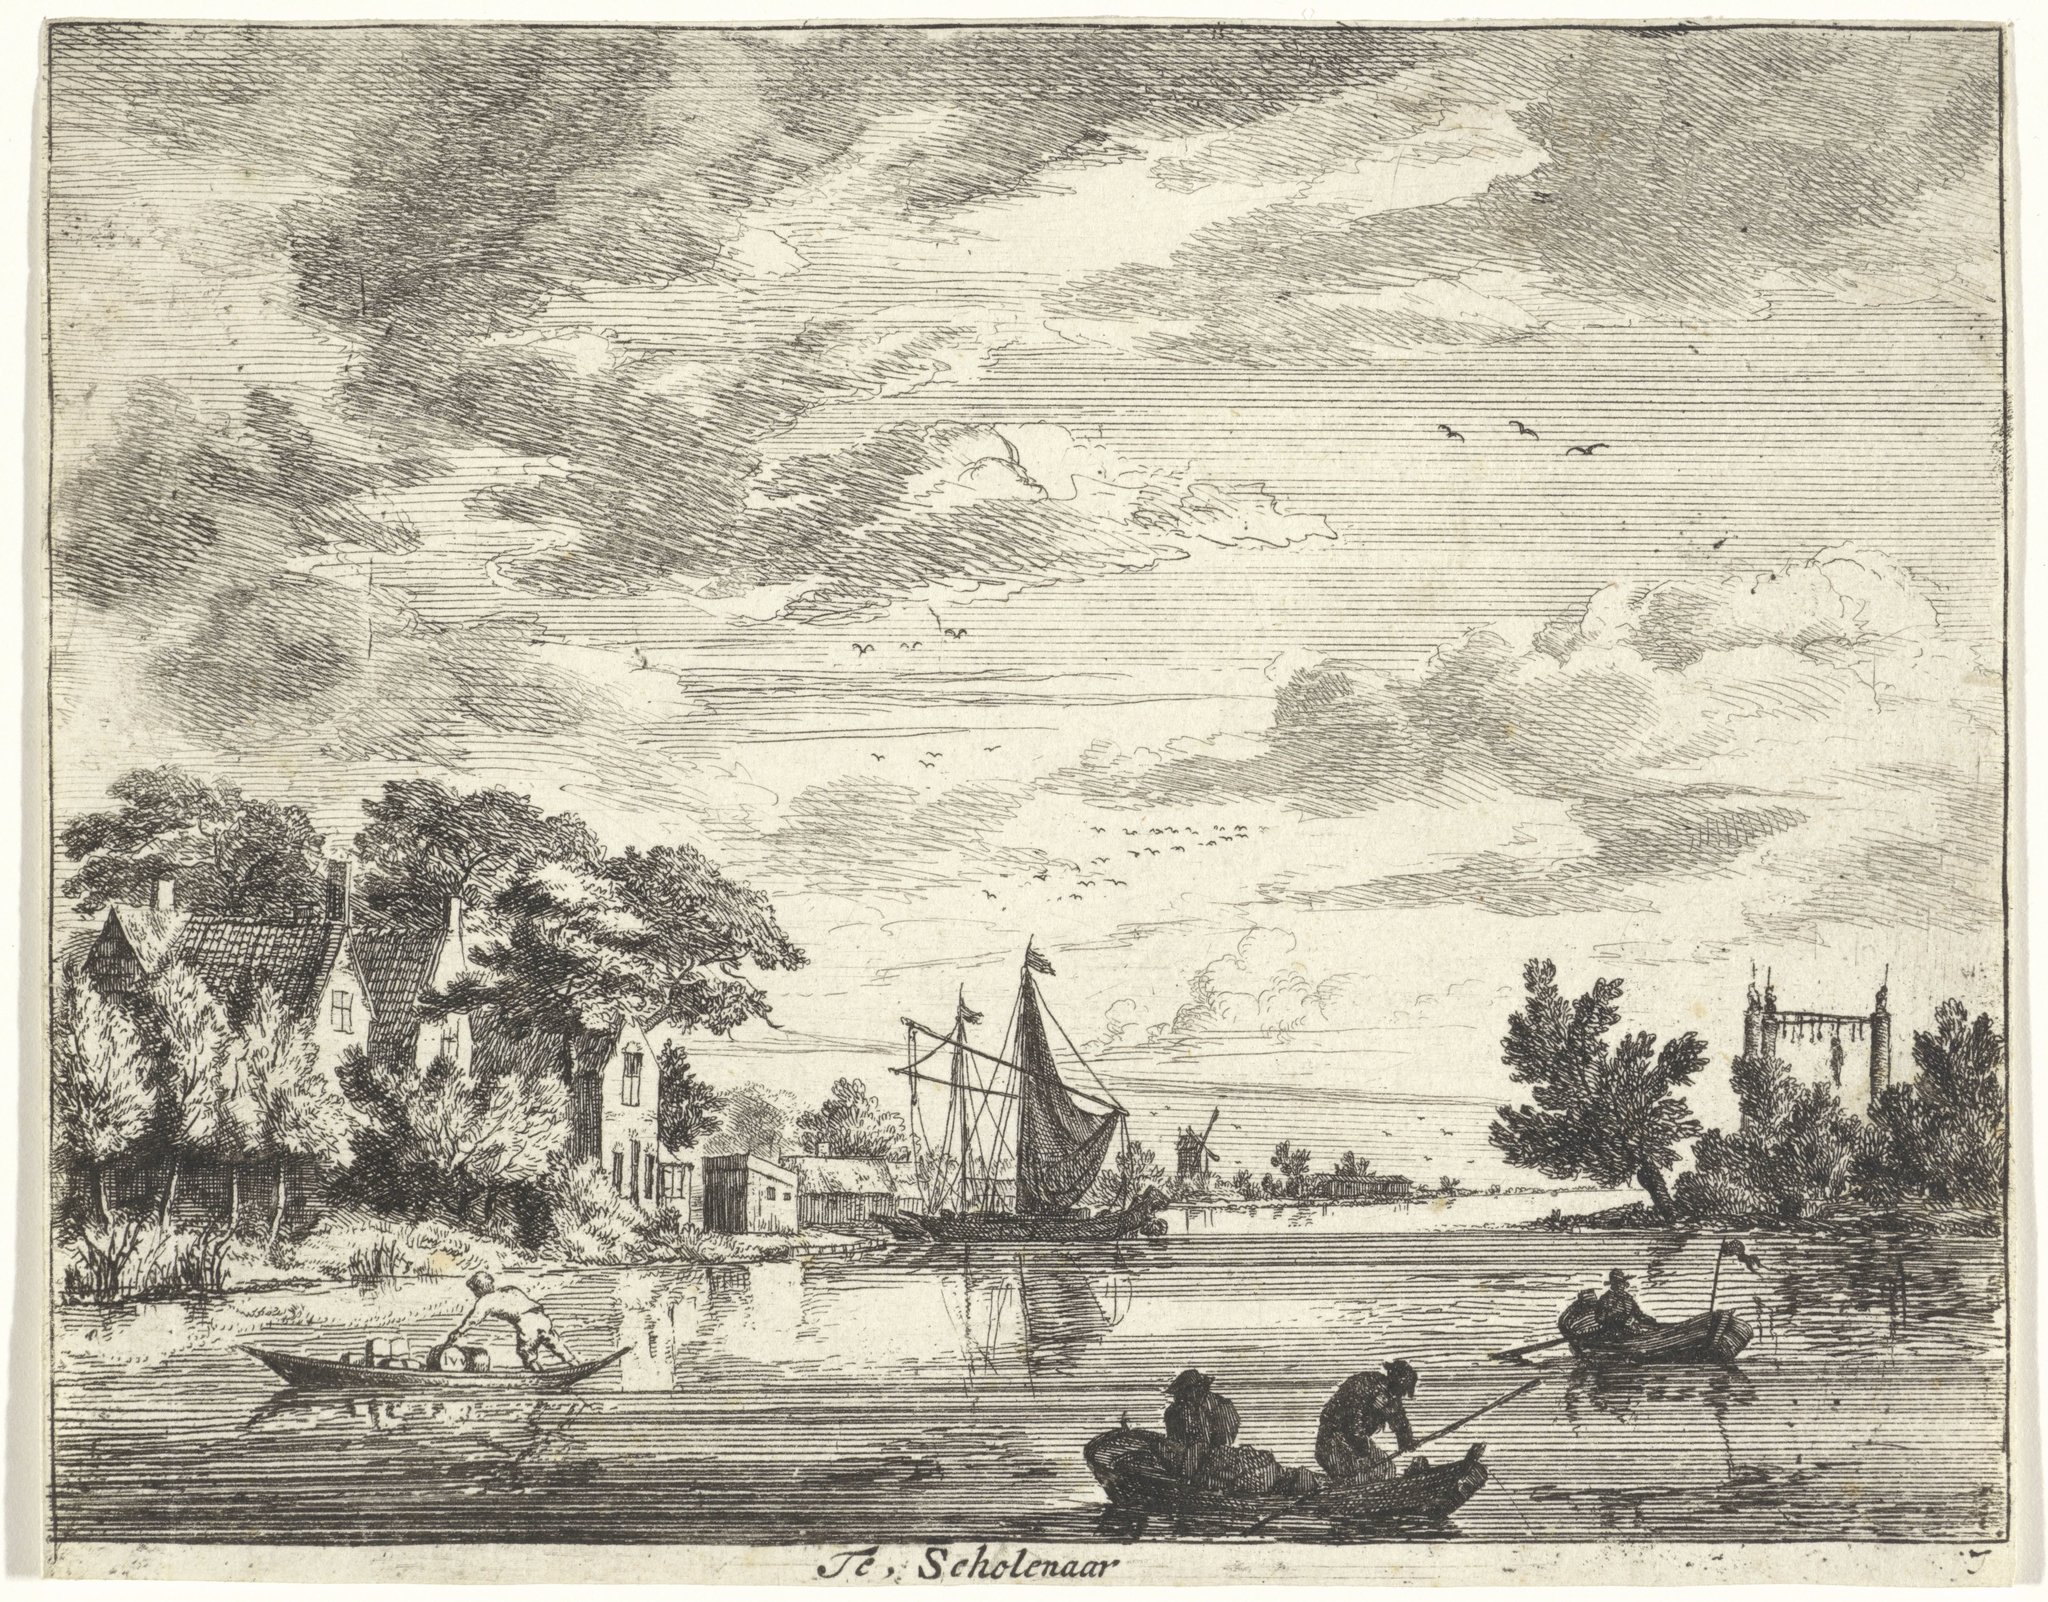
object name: print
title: Bedrijvigheid op een rivier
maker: jan vincentsz. van der vinne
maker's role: draughtsman, print maker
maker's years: 1663-1721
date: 1688-1690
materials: paper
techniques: etching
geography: haarlem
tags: instruments of torture, execution or punishment: gallows, dusk, evening twilight, sailing-ship, sailing-boat, river, rowing-boat, canoe, etc., haarlem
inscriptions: collector's mark: Lugt 240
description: Drie roeiboten en een zeilschip op een rivier bij een vallende avond. Rechts een galgenveld. Rechtsonder genummerd: 7.